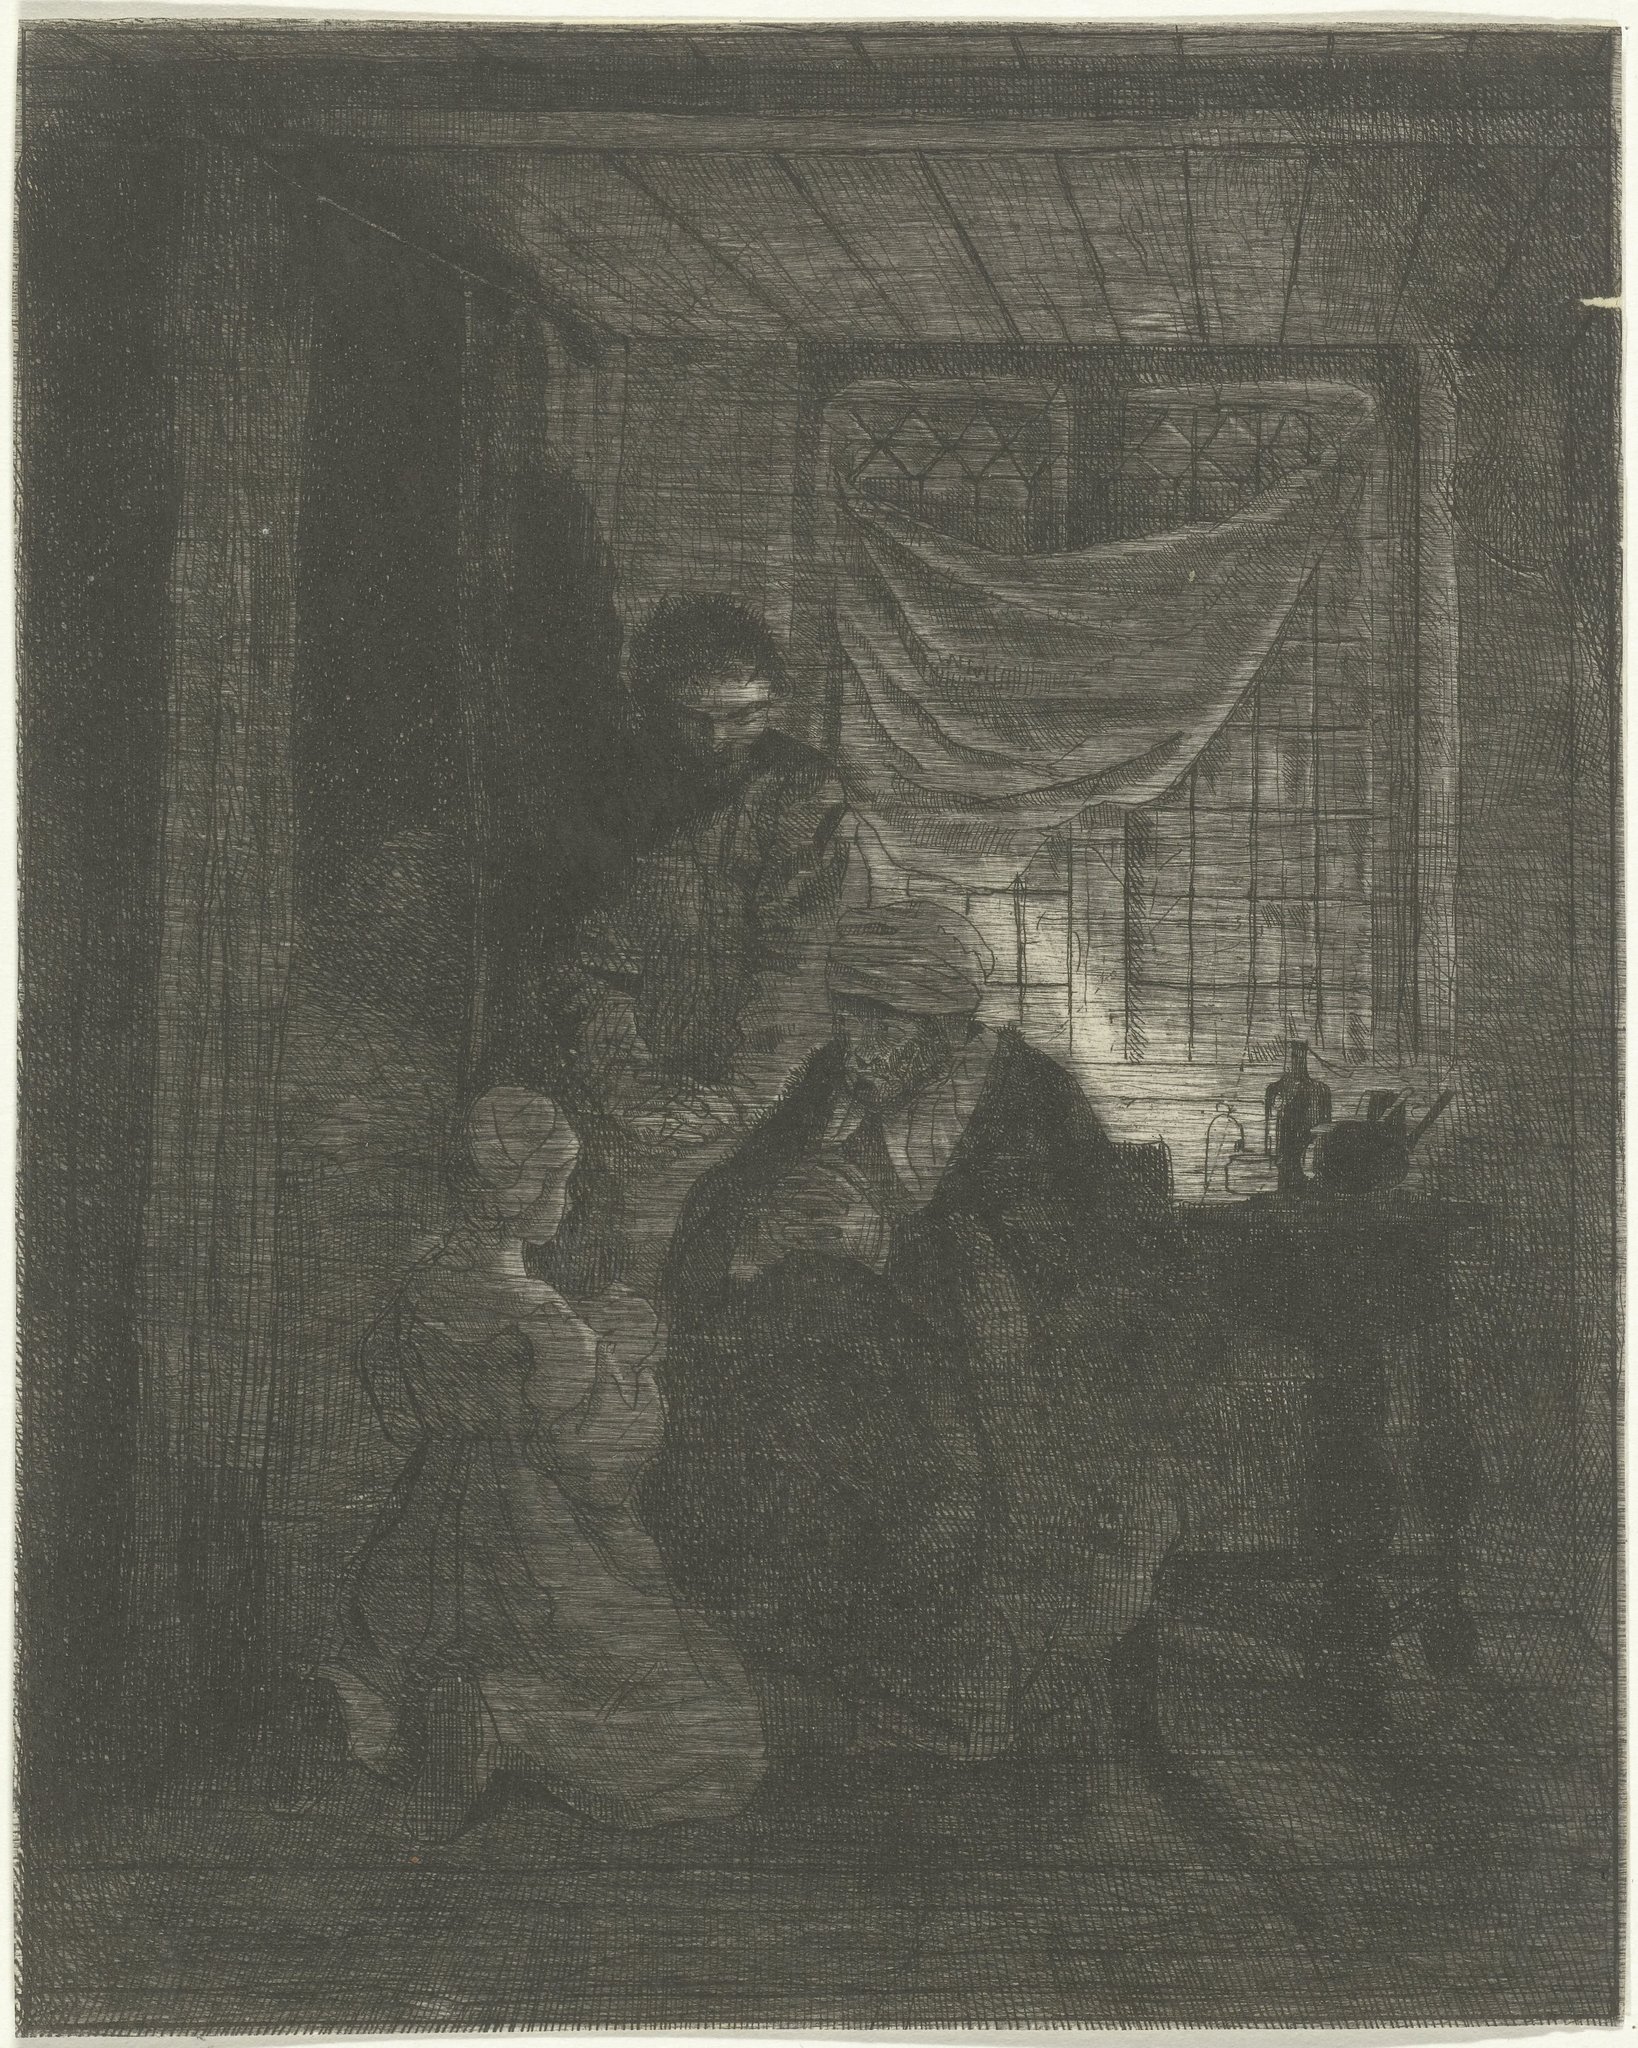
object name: print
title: Biddend gezin voor een bedstede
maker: jacobus ludovicus cornet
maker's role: draughtsman, print maker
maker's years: 1815-1882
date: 1825-1882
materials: paper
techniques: etching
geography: leiden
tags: (public) prayer, sick-bed, family group, especially parents with their child(ren)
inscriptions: collector's mark: Lugt 2228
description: Een woonkamer waar een man, een oude vrouw en een kind samen bidden voor een bedstede. In het bed ligt een zieke.